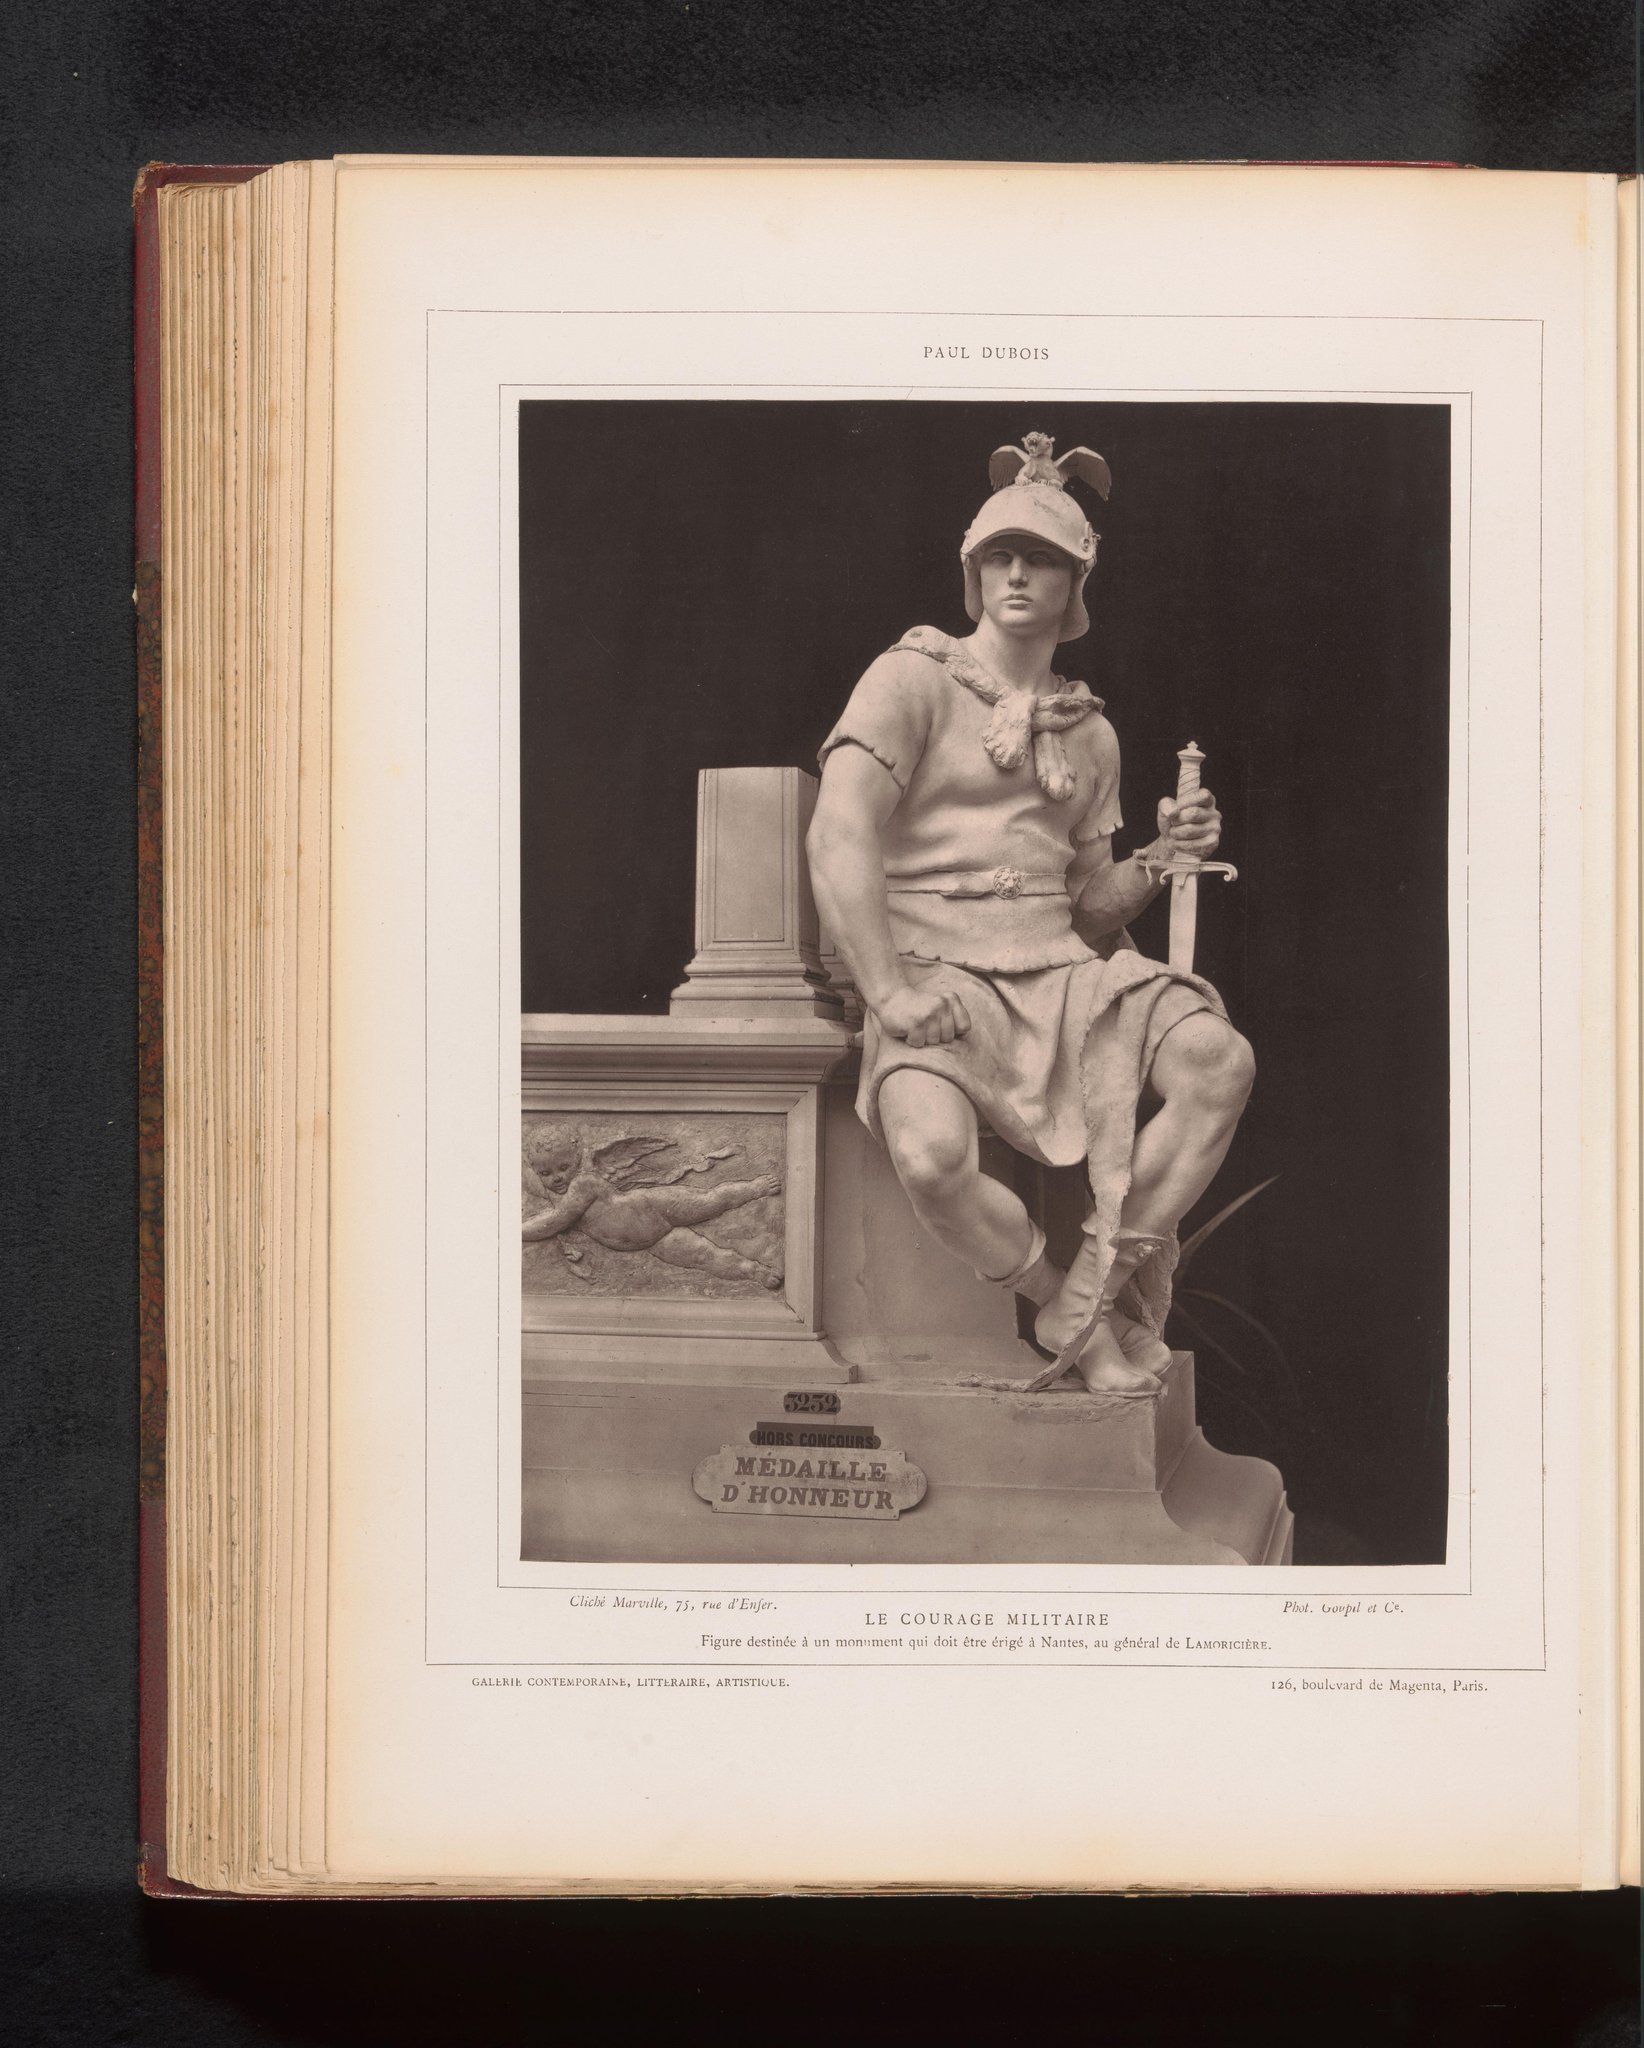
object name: page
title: Sculptuur Le courage militaire door Paul Dubois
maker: charles marville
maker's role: print maker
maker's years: 1816-1879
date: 1872-1877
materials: paper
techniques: woodburytype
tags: the soldier; the soldier's life, sculpture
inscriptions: inscription: ‘Paul Dubois/ Galerie Contemporaine, Littéraire, Artistique/ 126, boulevard de Magenta, Paris.’